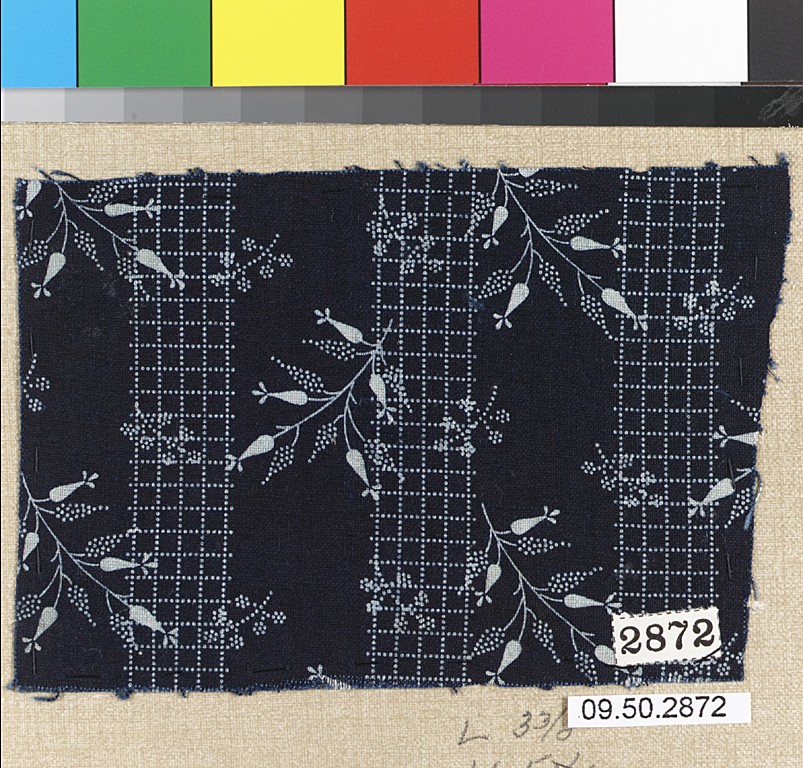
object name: piece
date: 1801-1900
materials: cotton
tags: leaves